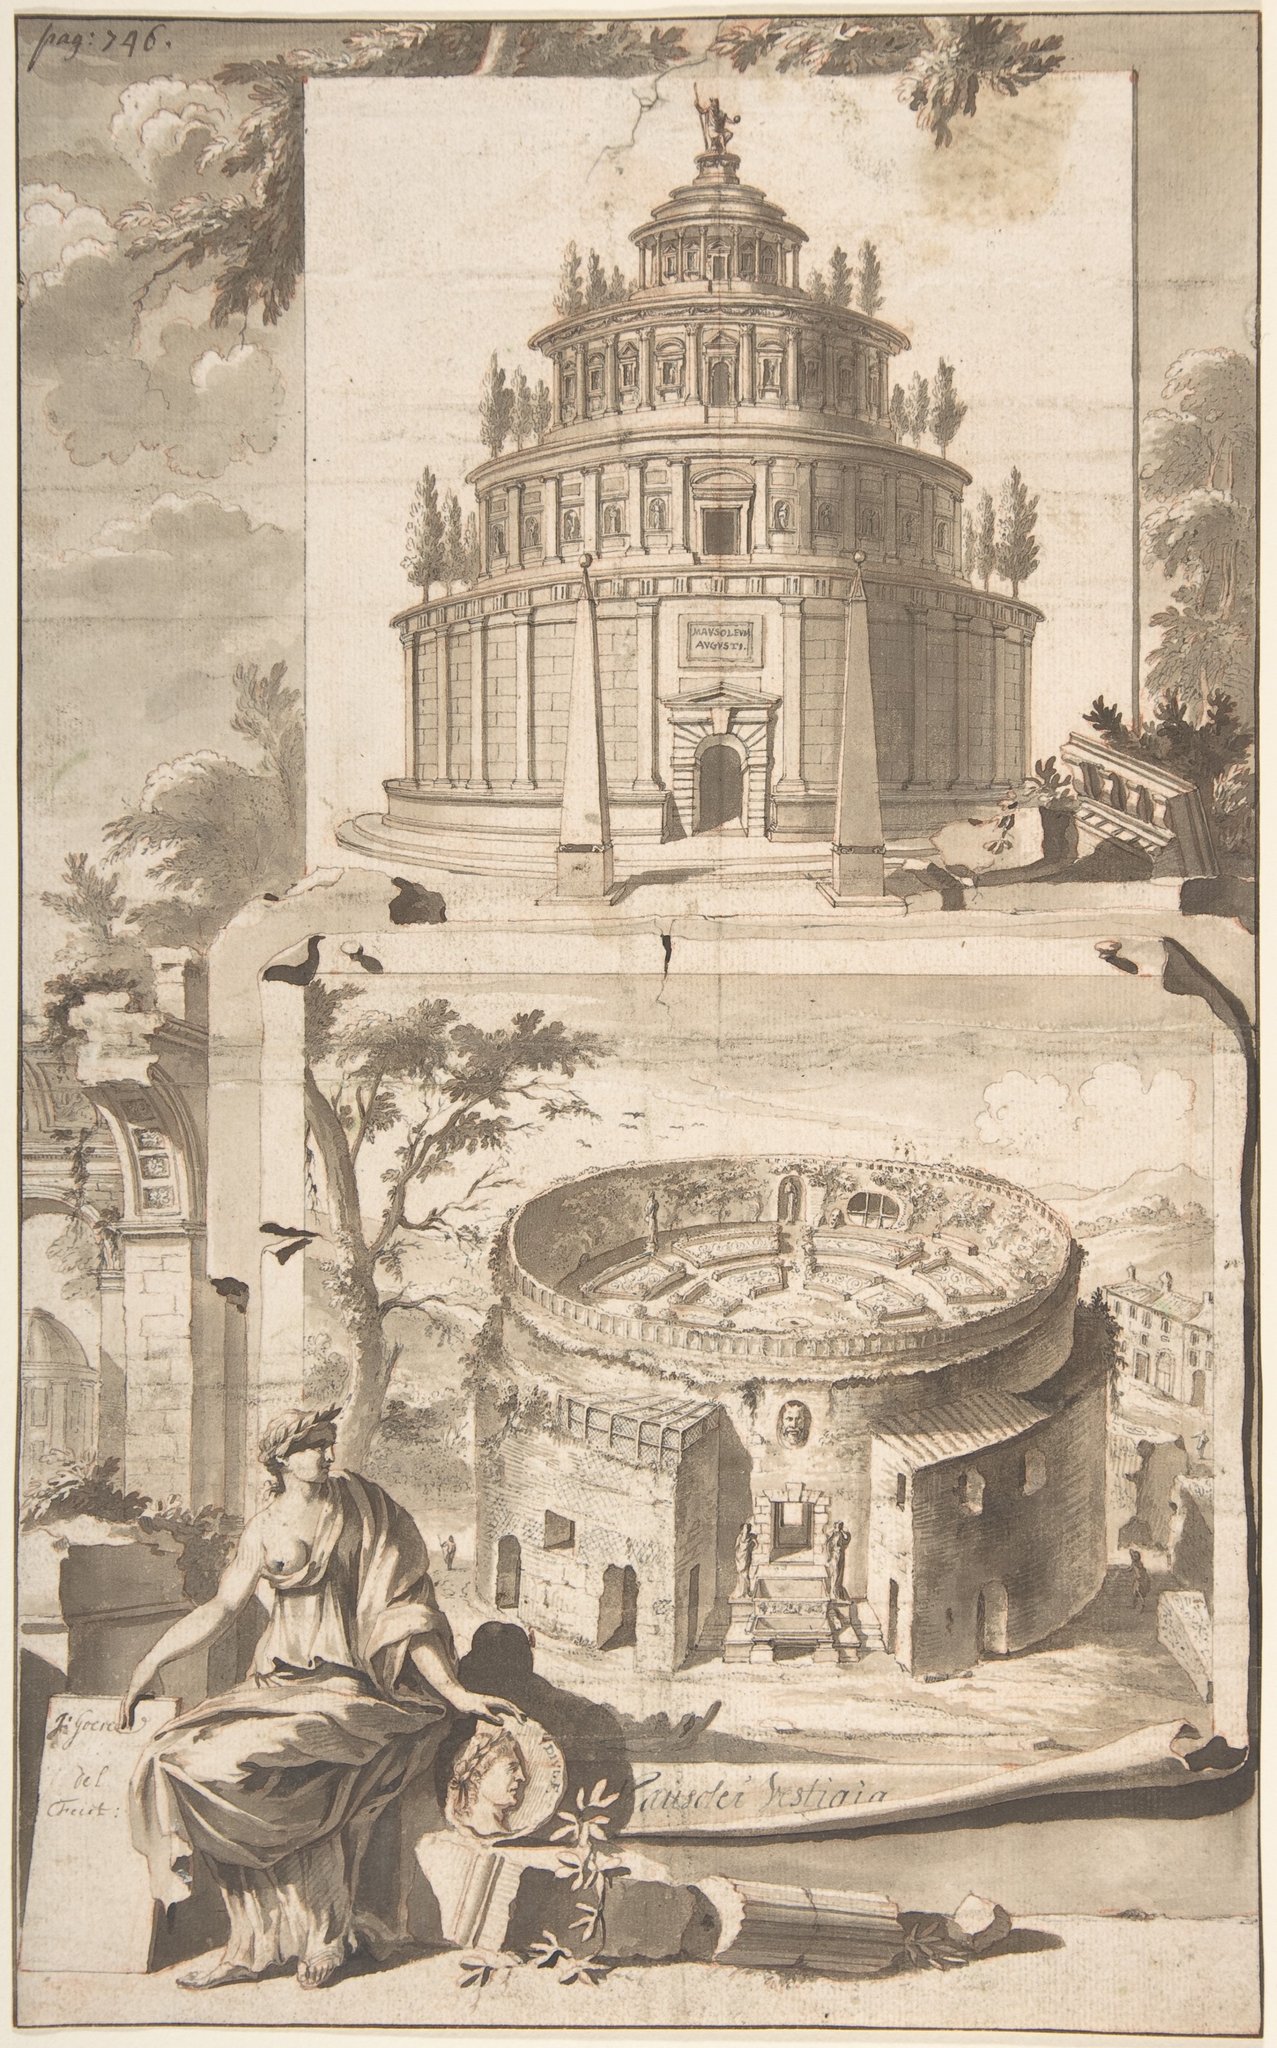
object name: drawing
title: A Reconstruction of the Mausoleum of Augustus (above) and a View of the Ruins (below)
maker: jan goeree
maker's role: artist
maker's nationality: dutch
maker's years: 1670-1731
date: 1704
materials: chalk, ink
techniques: brush, pen, wash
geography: italy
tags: buildings,women,trees